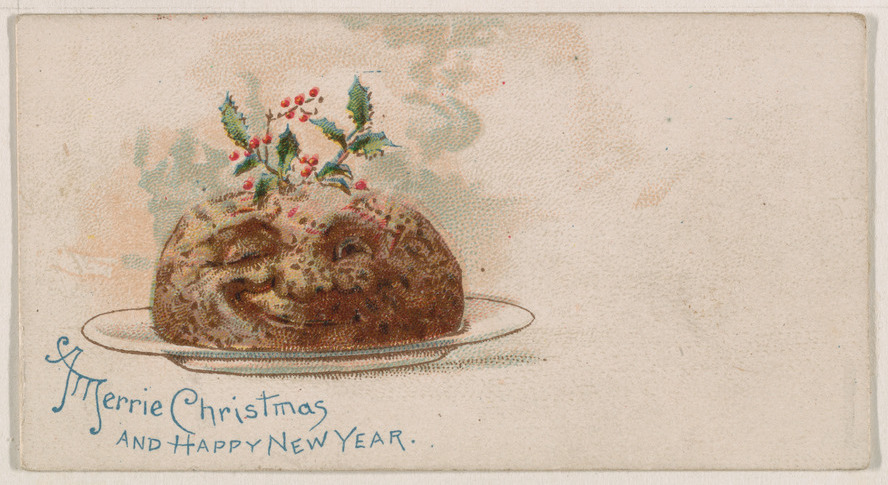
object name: print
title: Merry Christmas and Happy New Year, from the New Years 1890 series (N227) issued by Kinney Bros.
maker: kinney brothers tobacco company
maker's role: publisher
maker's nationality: american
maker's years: 1869-2011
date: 1889-1890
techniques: color lithograph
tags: food,cherries,christmas